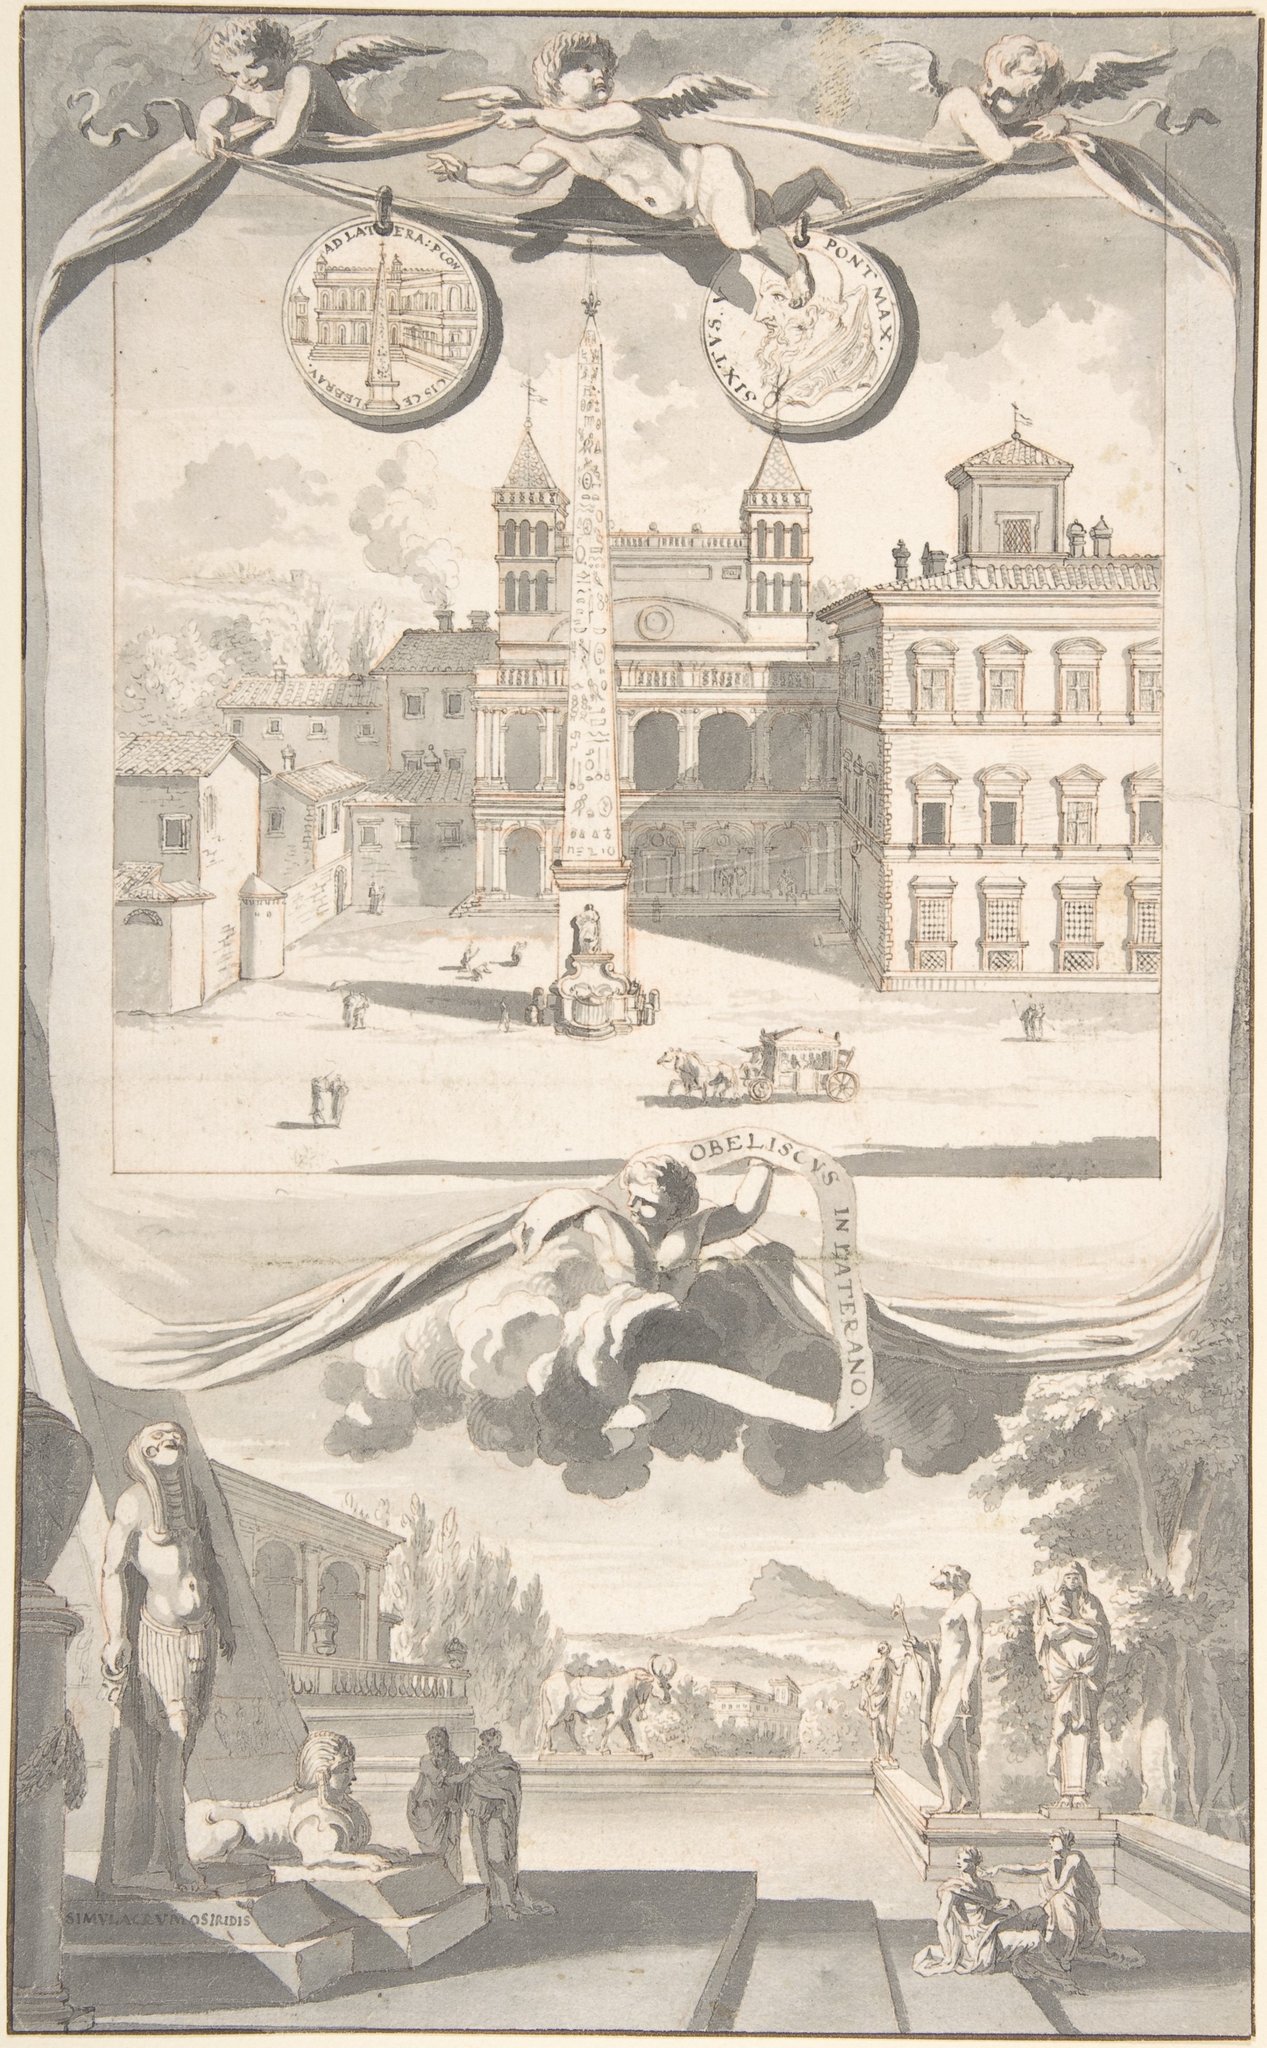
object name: drawing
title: A View of the Obelisk and Saint John in Lateran (above) and a View of an Egyptian Site (?) (below)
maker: jan goeree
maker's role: artist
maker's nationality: dutch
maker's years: 1670-1731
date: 1704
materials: chalk, graphite, ink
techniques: brush, incising, pen, wash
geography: italy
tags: buildings,obelisks,angels,saint john the baptist